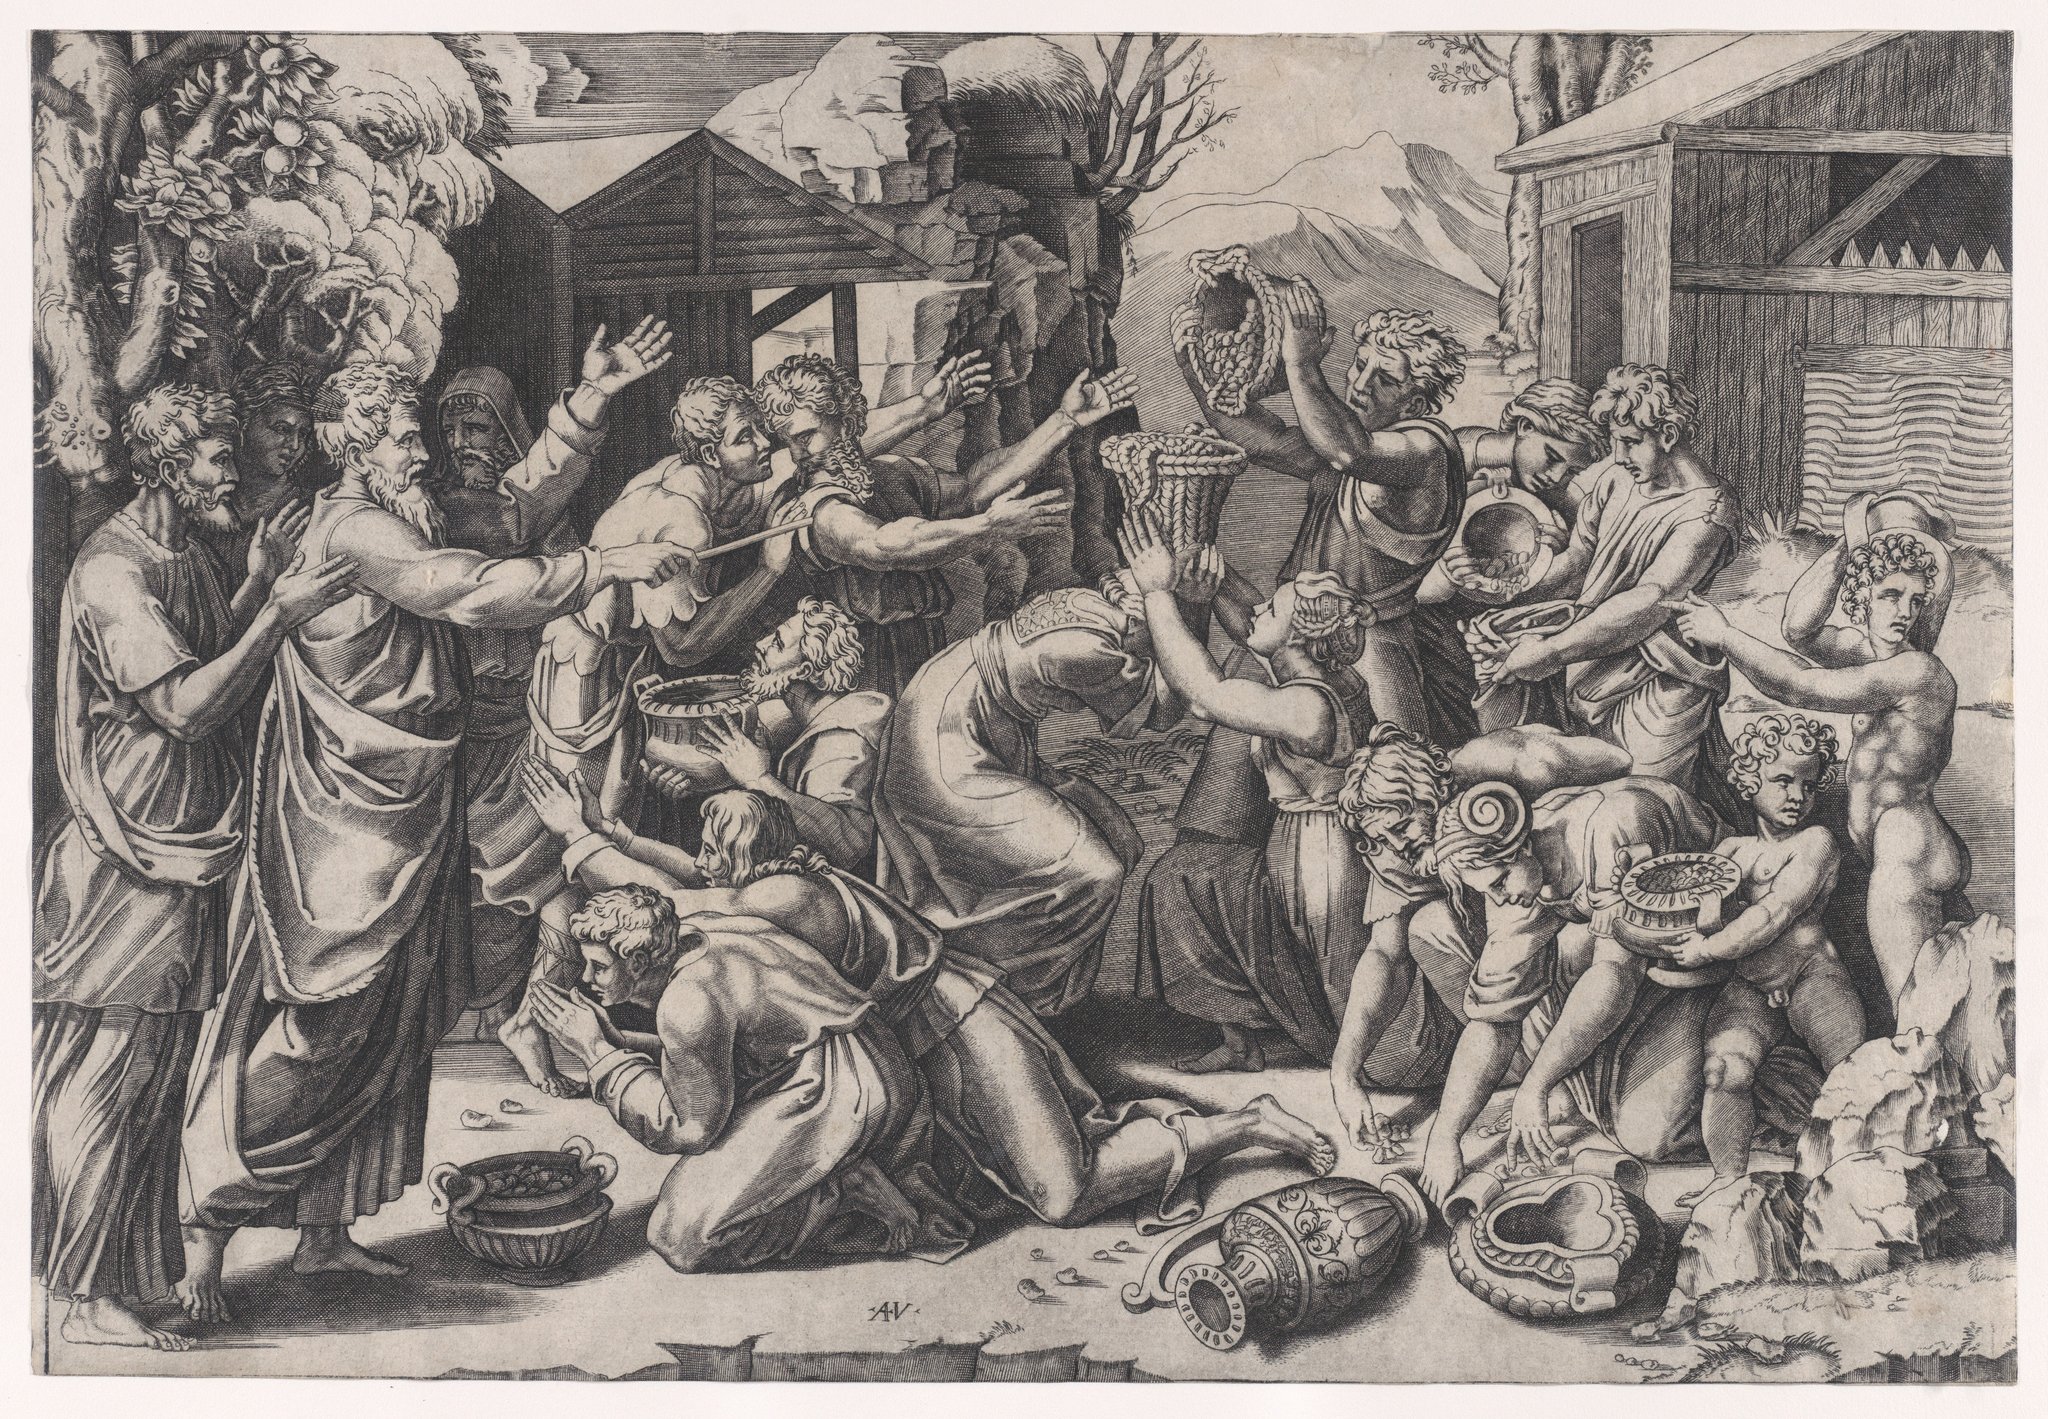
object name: print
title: The Israelites Gathering Manna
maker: agostino veneziano (agostino dei musi)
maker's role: artist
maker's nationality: italian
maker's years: 1490-1536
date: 1514-1536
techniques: engraving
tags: men,women,manna